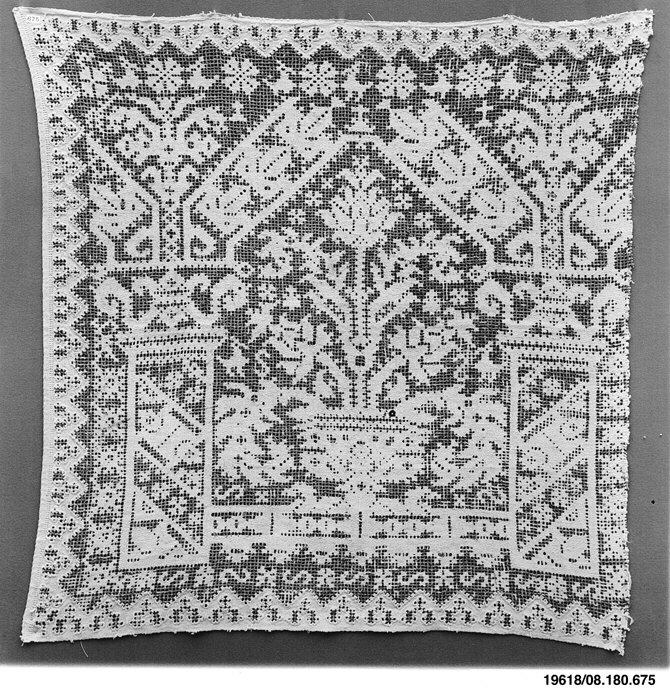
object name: valance fragment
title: Left end of a valance (?)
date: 1501-1600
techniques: embroidery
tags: birds,flowers